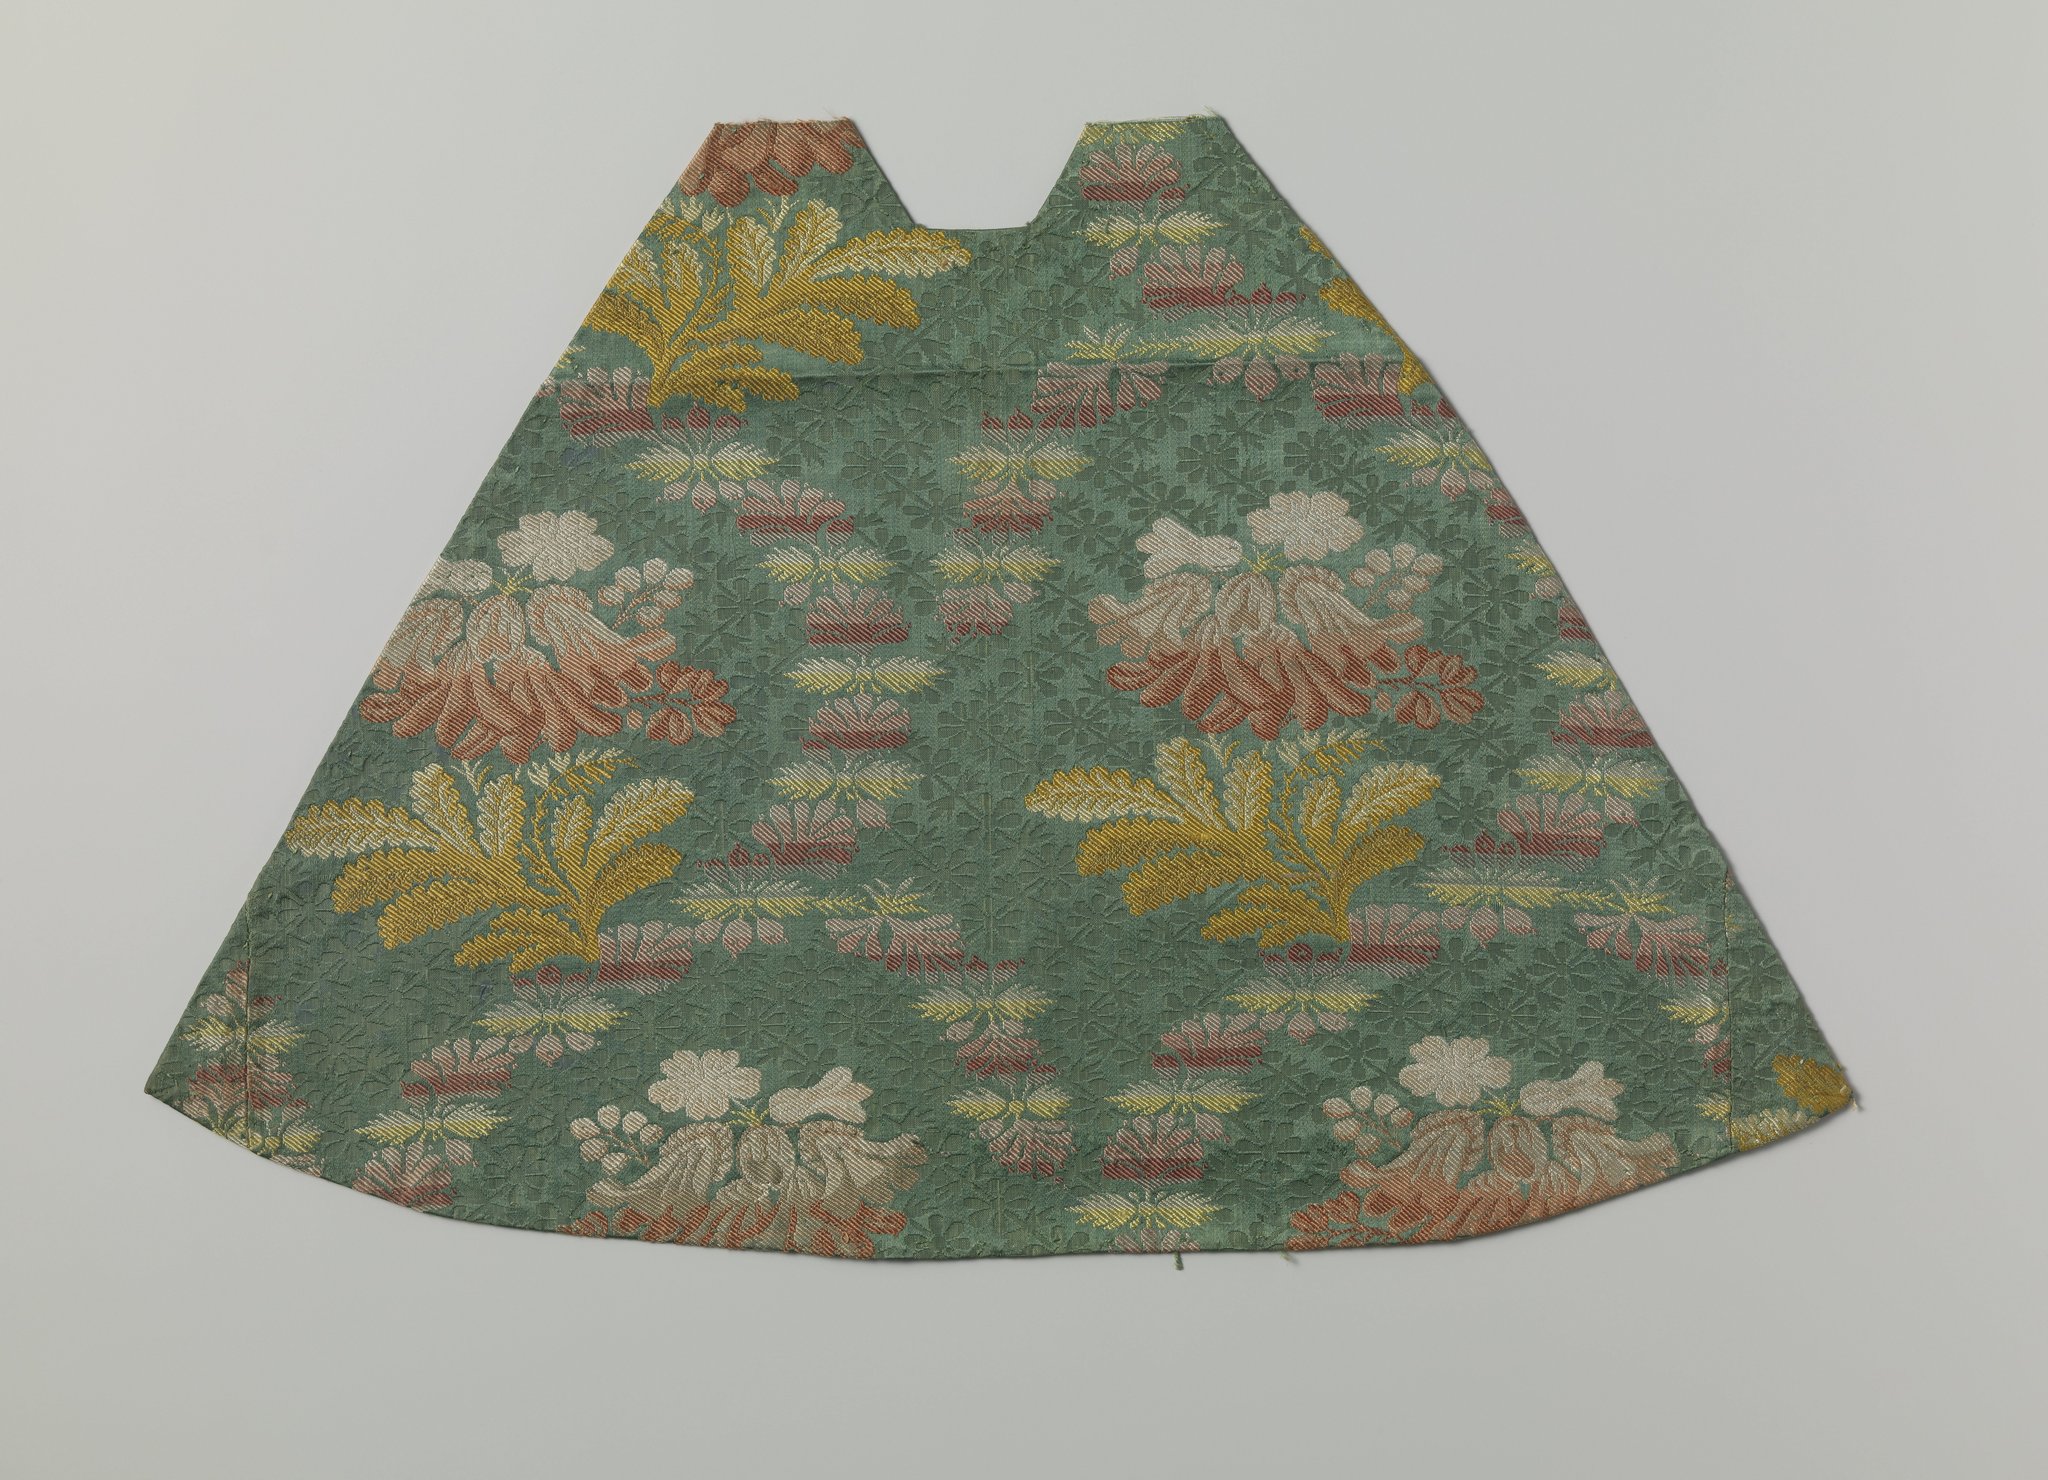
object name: woven material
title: Fragment veelkleurig gebrocheerde zijdedamast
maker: Anonymous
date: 1730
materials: silk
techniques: brocade, damask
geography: spain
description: Fragment zijdeweefsel met een groene grond met een patroon van zig-zag lijnen bestaande uit een gestileerd bloemmotief. Op het motief lopen slingers bestaande uit bladeren en vruchten. De slingers vormen velden waarbinnen bladeren, bloemen en vruchten.